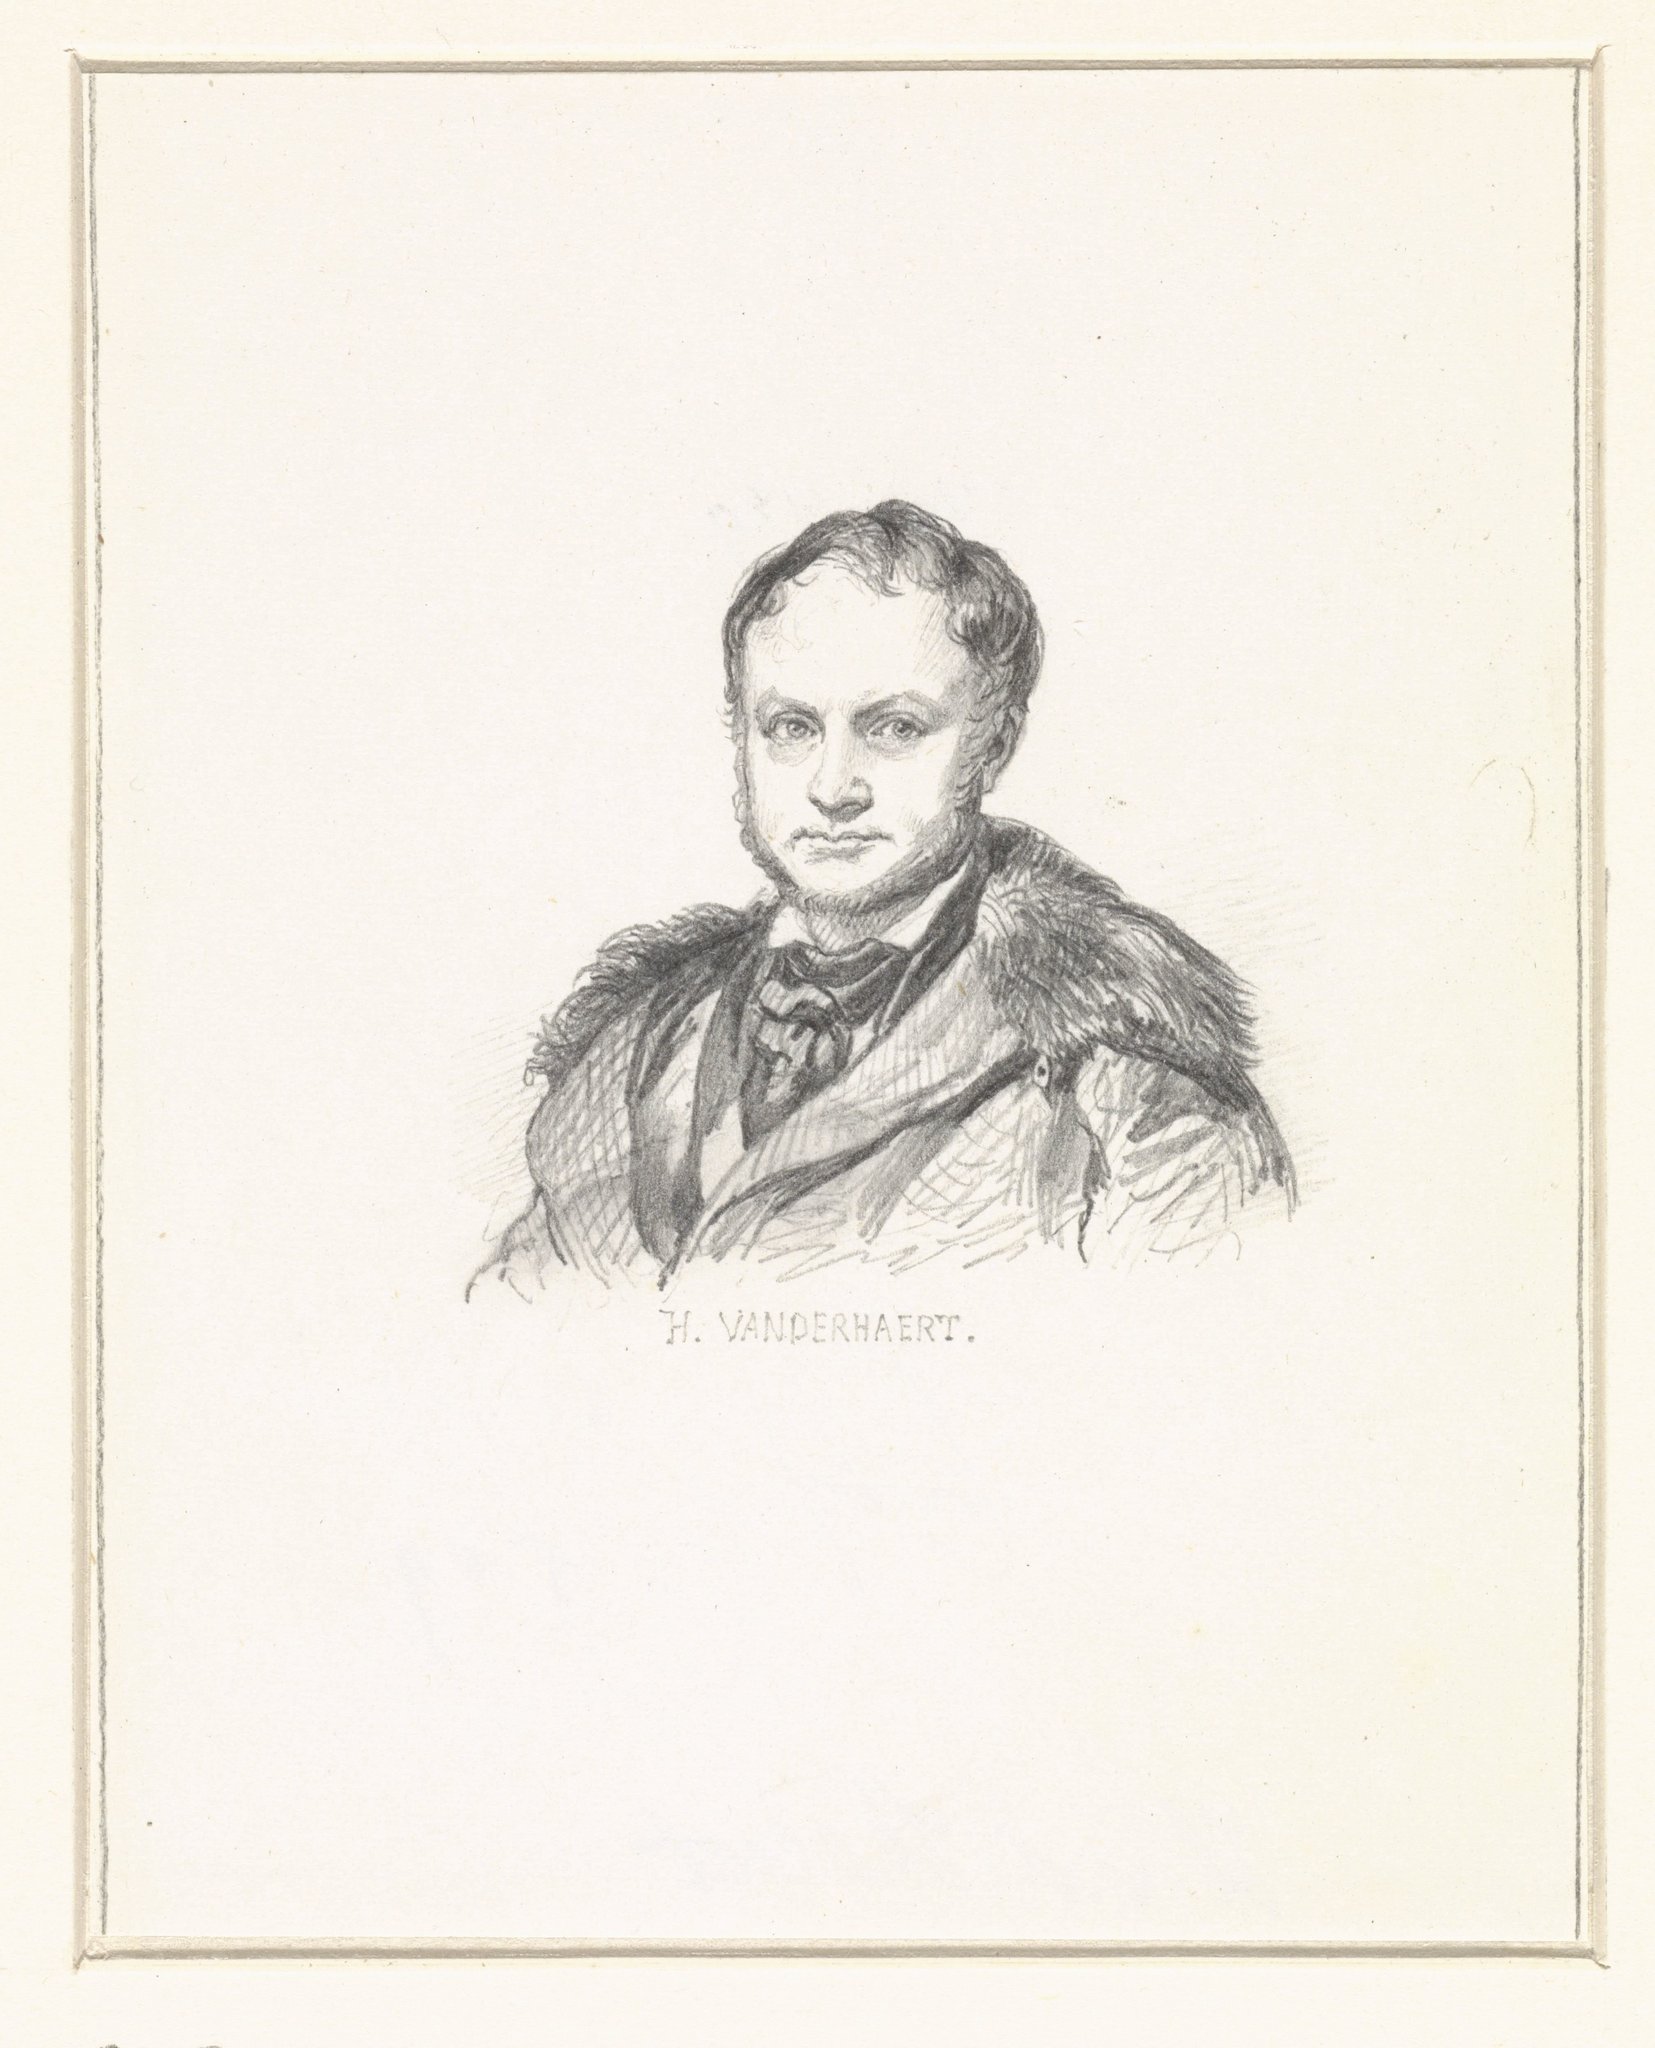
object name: drawing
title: Zelfportret van Henri Van der Haert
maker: henri van der haert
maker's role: draughtsman, print maker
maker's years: 1790-1846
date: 1840-1842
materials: paper, pencil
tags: louvain, ghent, print maker, henri van der haert, historical persons, portrait, self-portrait of painter, portrait, self-portrait of artist, portrait, self-portrait of draughtsman